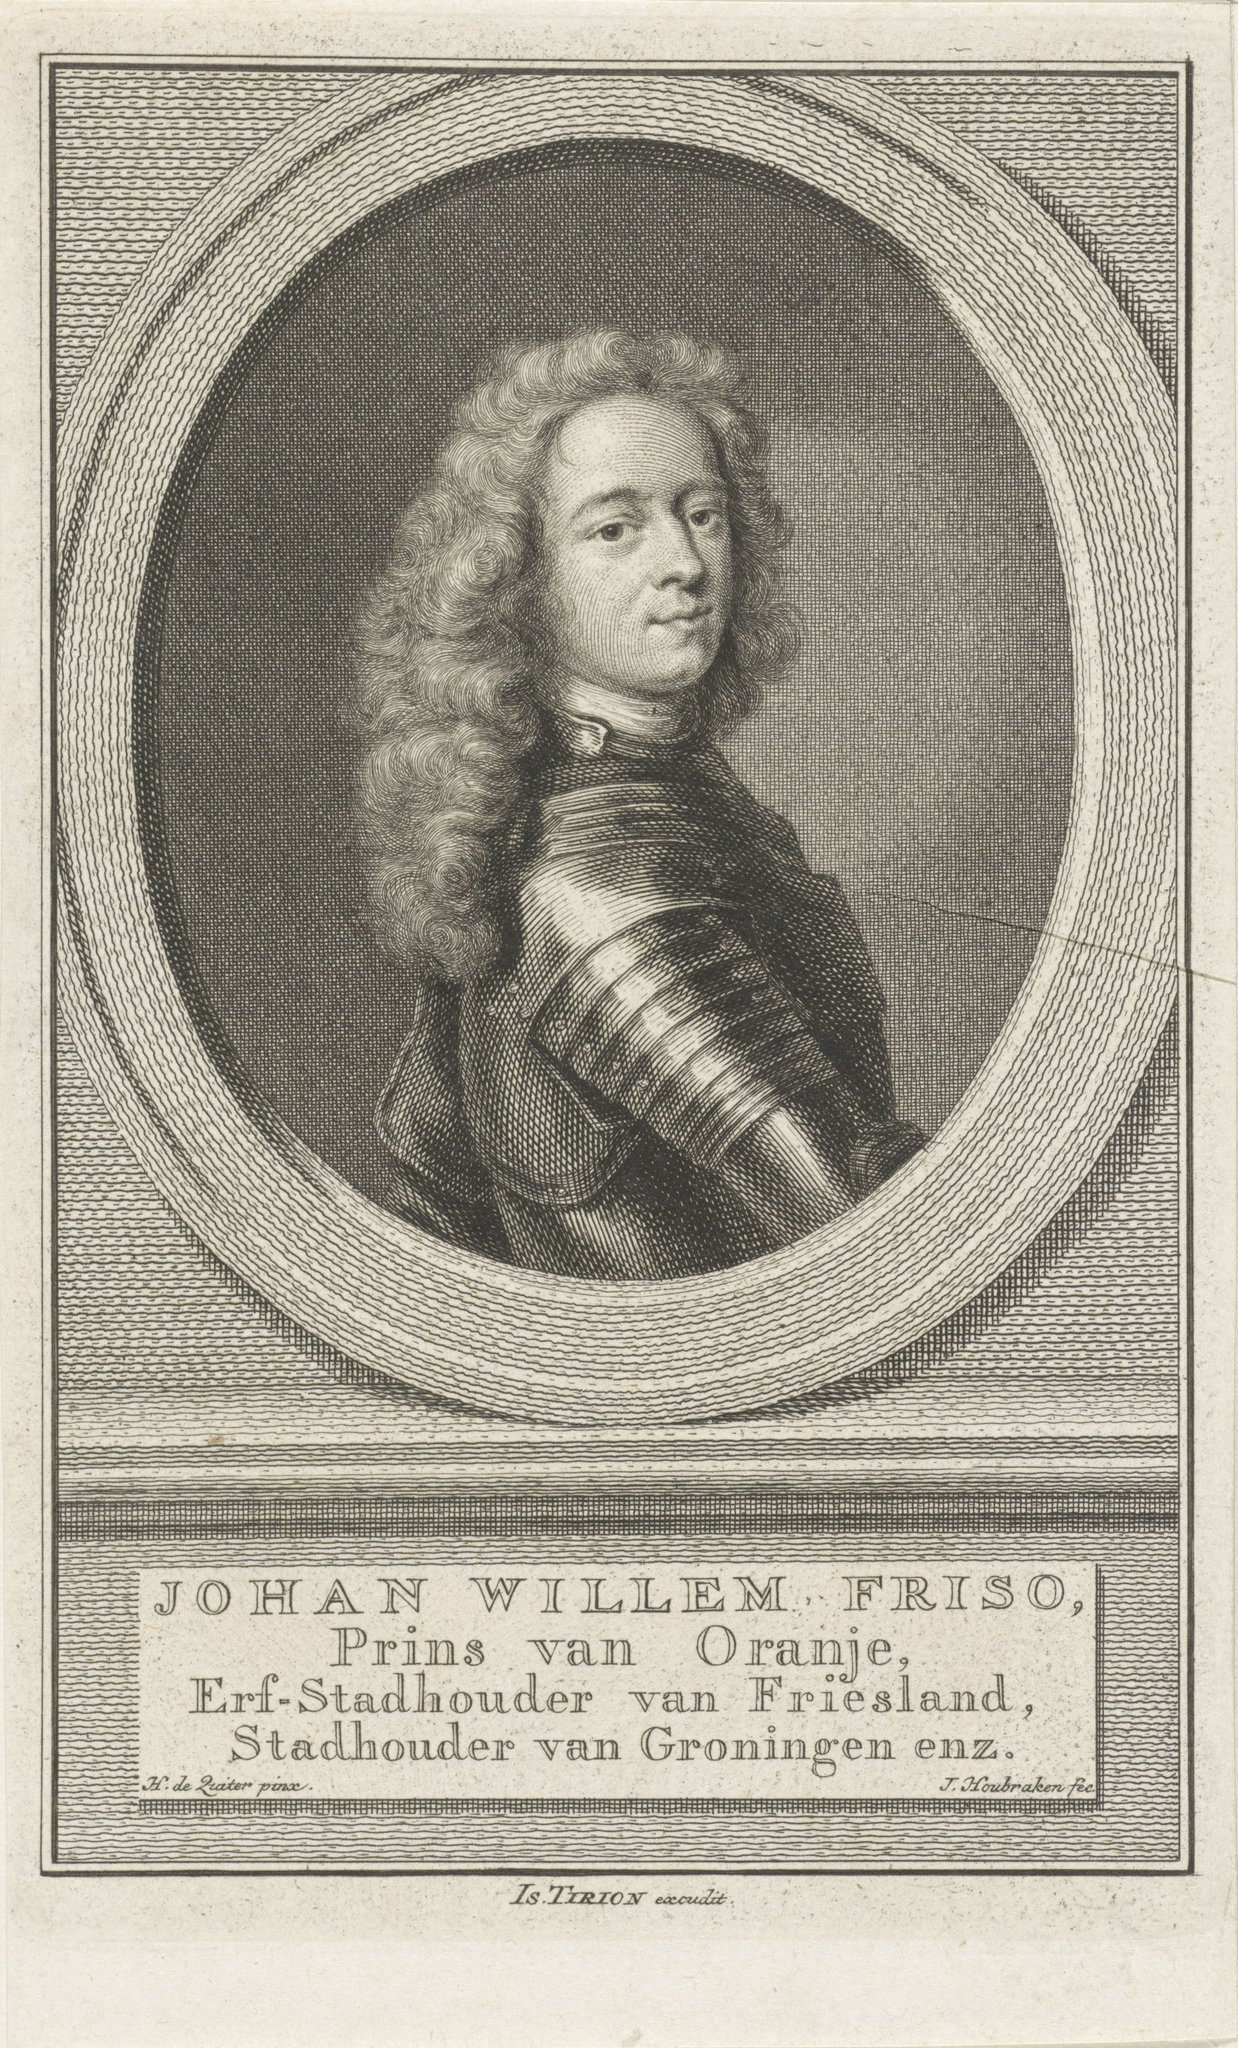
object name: print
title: Portret van Johan Willem Friso, prins van Oranje-Nassau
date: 1749-1759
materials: paper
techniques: engraving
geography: amsterdam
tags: johan willem friso (prins van oranje-nassau)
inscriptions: collector's mark: Lugt 2165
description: De hier vermelde titel verwijst naar de hoogst verkregen titel van de geportretteerde, niet per se naar de titel die de geportretteerde op deze voorstelling draagt. Prent uit: Wagenaar, Jan. Vaderlandsche historie. Amsterdam: Isaak Tirion, 1749-1759.